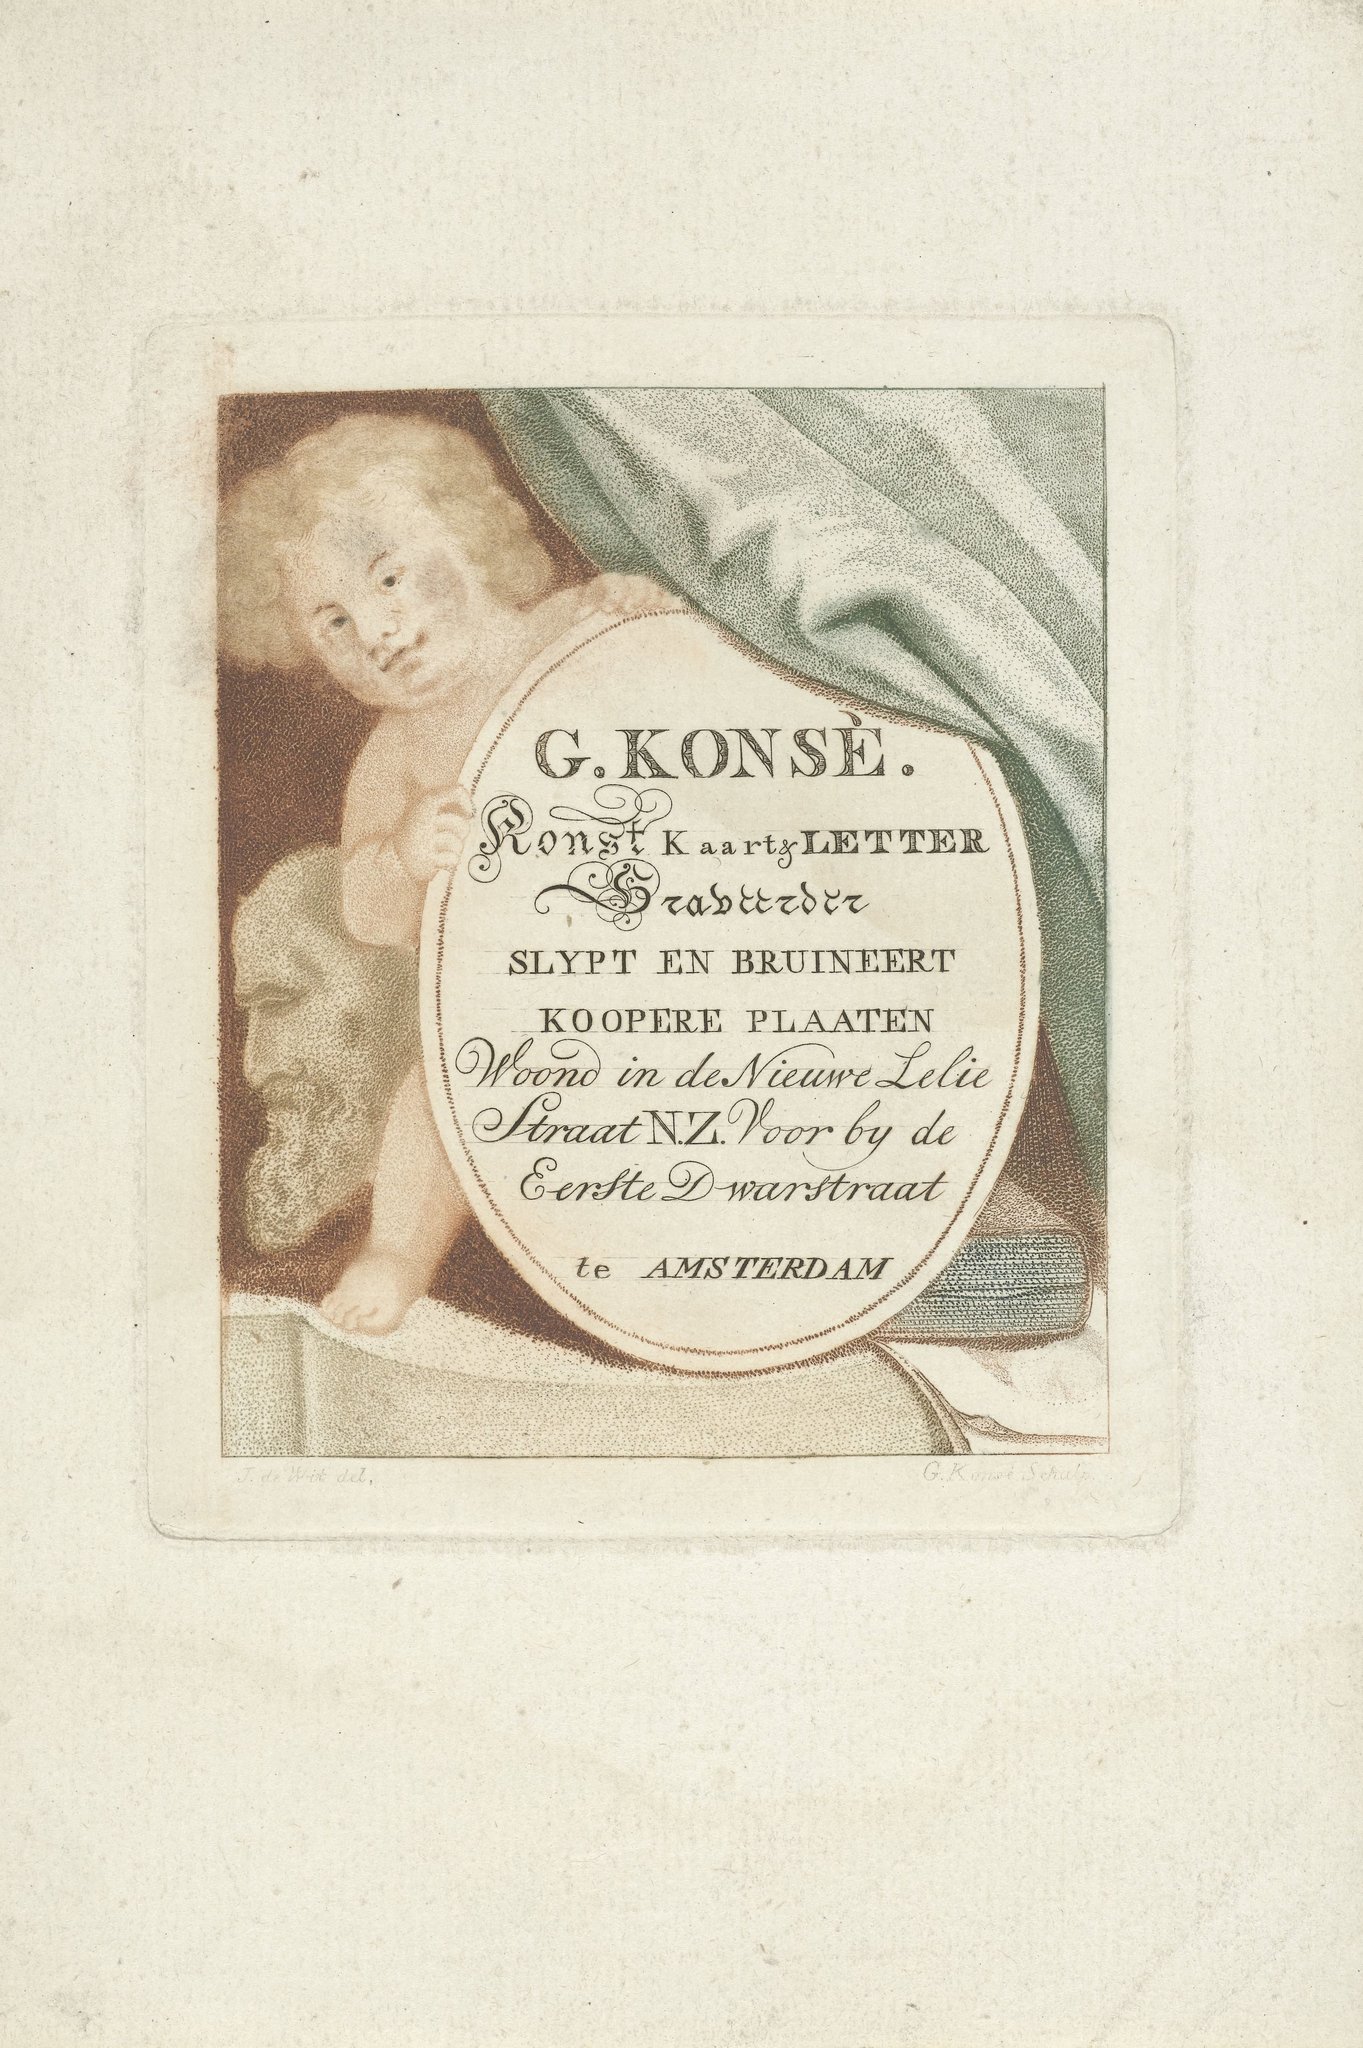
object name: print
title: Visitekaart van Gerrit Konsé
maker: gerrit konsé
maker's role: print maker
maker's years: 1751-1826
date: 1761-1828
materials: paper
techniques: etching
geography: netherlands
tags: visiting-card, calling-card, cupids: 'amores', 'amoretti', 'putti'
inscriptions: collector's mark: Lugt 2228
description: Visitekaart van de graveur Gerrit Konsé. Een putto houdt het ovale bord met de reclametekst op.